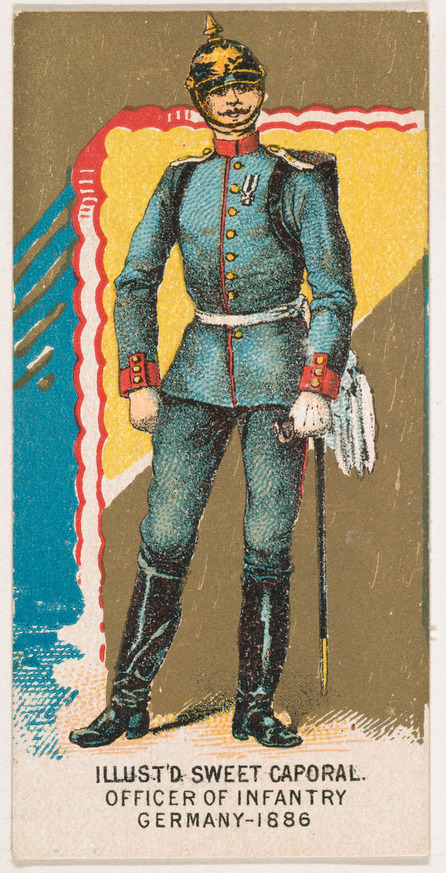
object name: print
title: Officer of Infantry, Germany, 1886, from the Military Series (N224) issued by Kinney Tobacco Company to promote Sweet Caporal Cigarettes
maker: kinney brothers tobacco company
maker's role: publisher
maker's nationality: american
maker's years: 1869-2011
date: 1888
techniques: color lithograph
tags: military,men